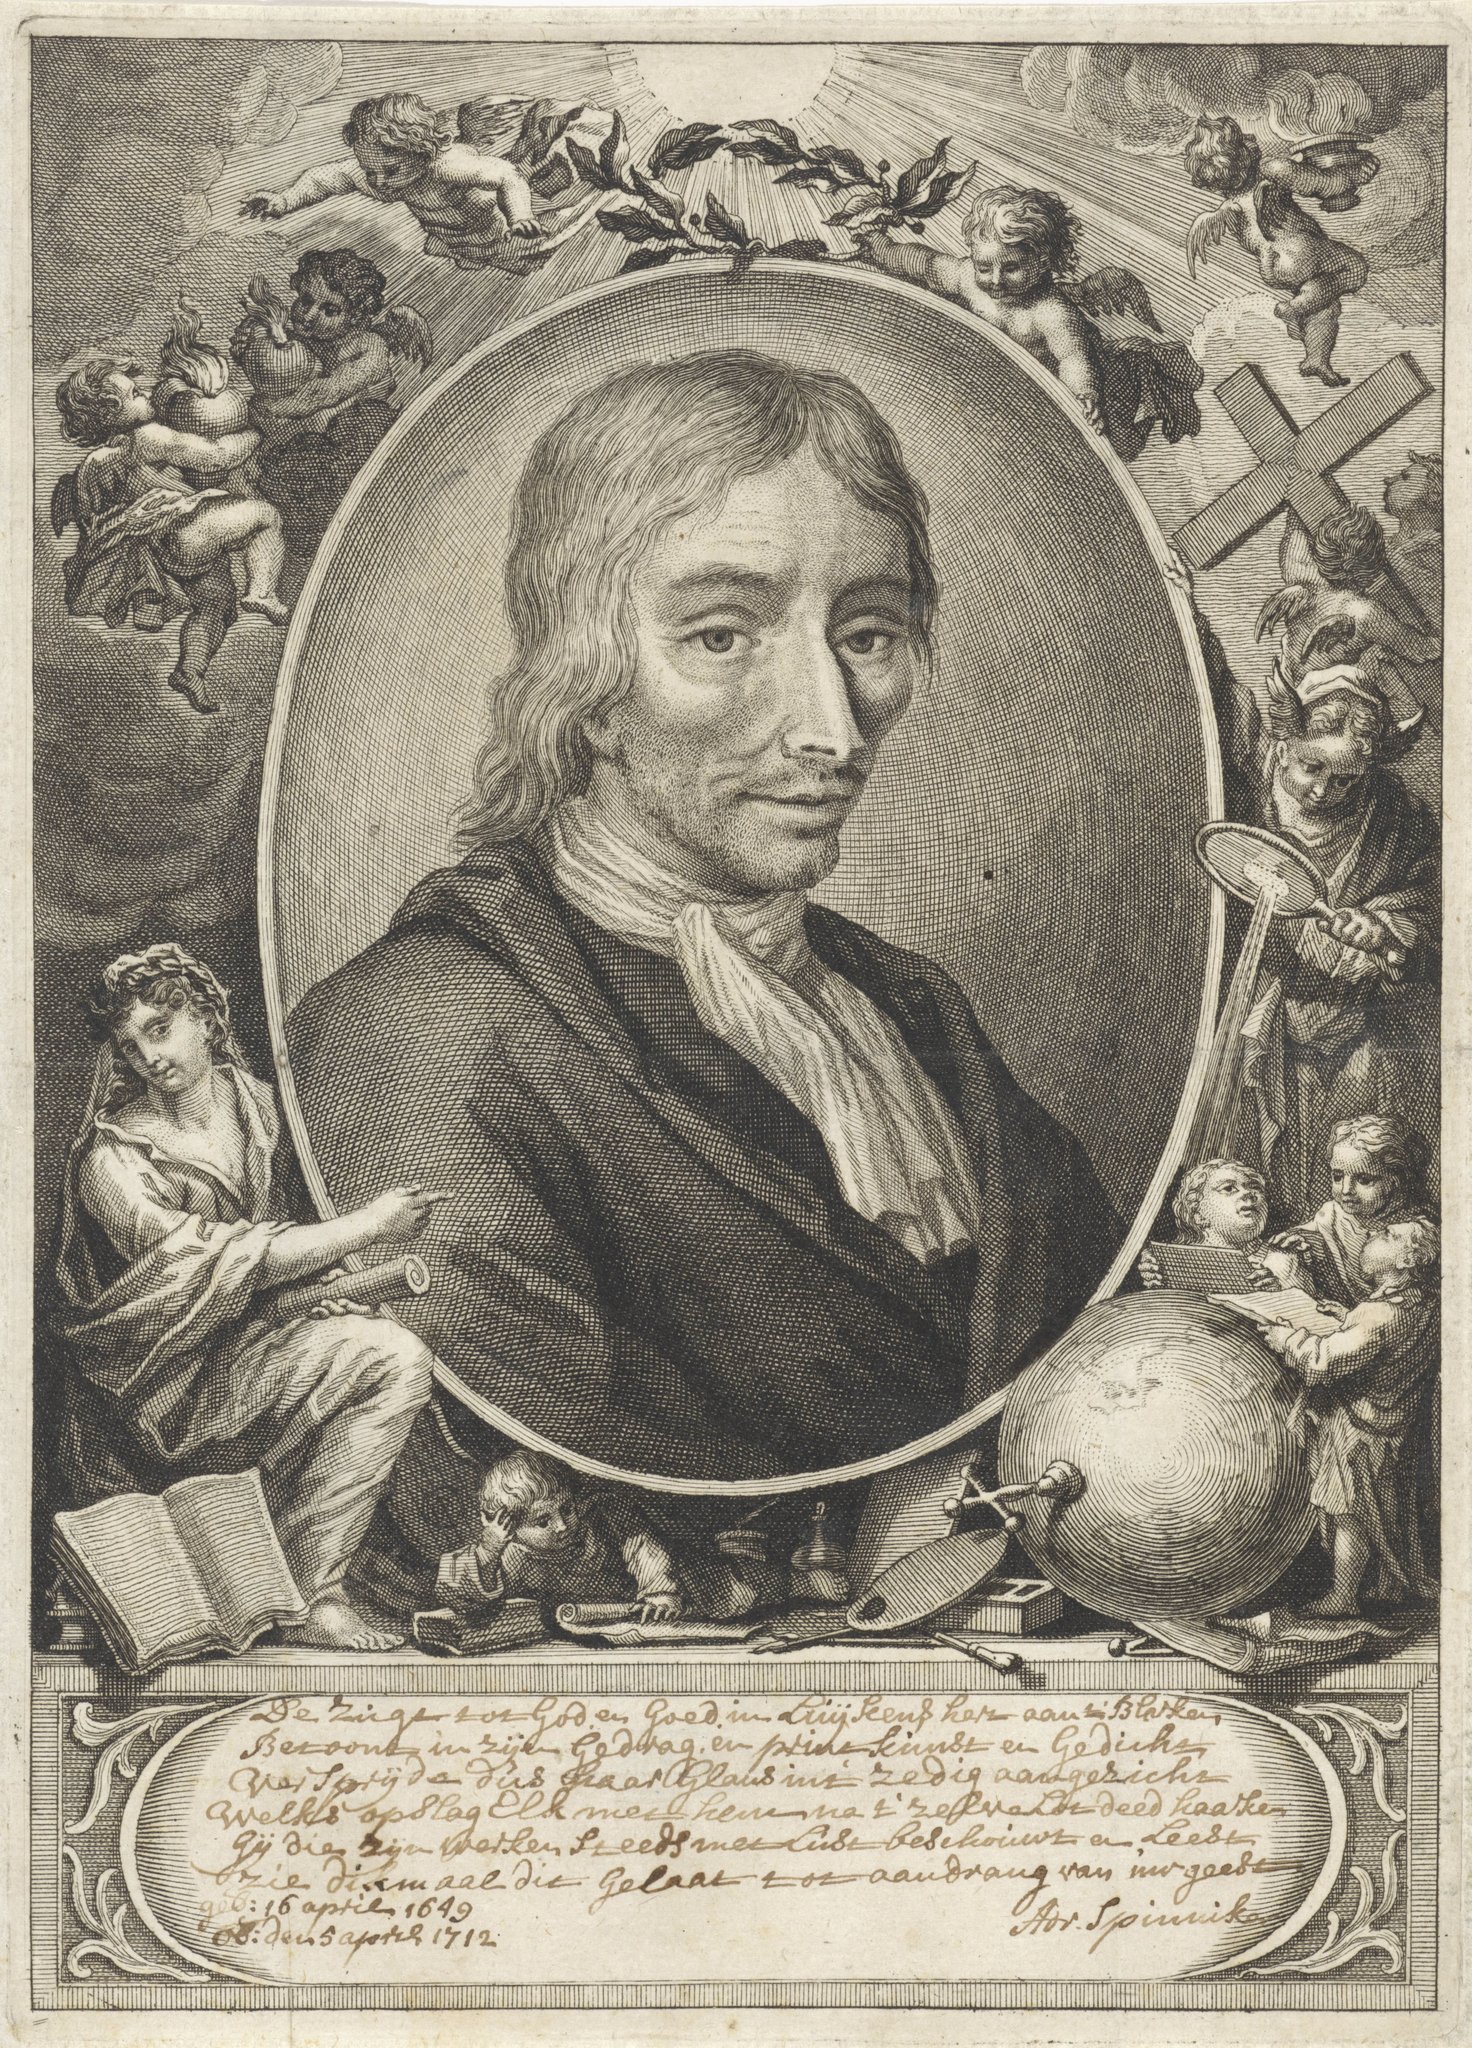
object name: print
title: Portret van Jan Luyken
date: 1712-1713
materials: ink, paper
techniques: engraving, etching, pen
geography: amsterdam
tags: draughtsman, jan luyken, orb (symbol of sovereignty; sphere with cross on top), cross as symbol of christ, the sacred heart, portrait, self-portrait of graphic artist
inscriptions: collector's mark: Lugt 2228, inscription:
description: Portret van de prentmaker, schilder en dichter Jan Luyken. Boven het ovaal met het portret houdt een putto een lauwerkrans vast. Andere putti dragen een kruis, wierookvat of brandende harten. Op de grond ligt een rijksappel waarbij lezende kinderen staan, die afgeleid worden door een figuur met een gevleugeld hoofddeksel, mogelijk Mercurius. Deze laat door een vergrootglas zonlicht vallen op het tafereel onder hem. Op de grond liggen teken- en schildersbenodigdheden en boeken. Een vrouw met een boekrol in de hand wijst op het portret. Op het piëdestal een opengelaten cartouche.